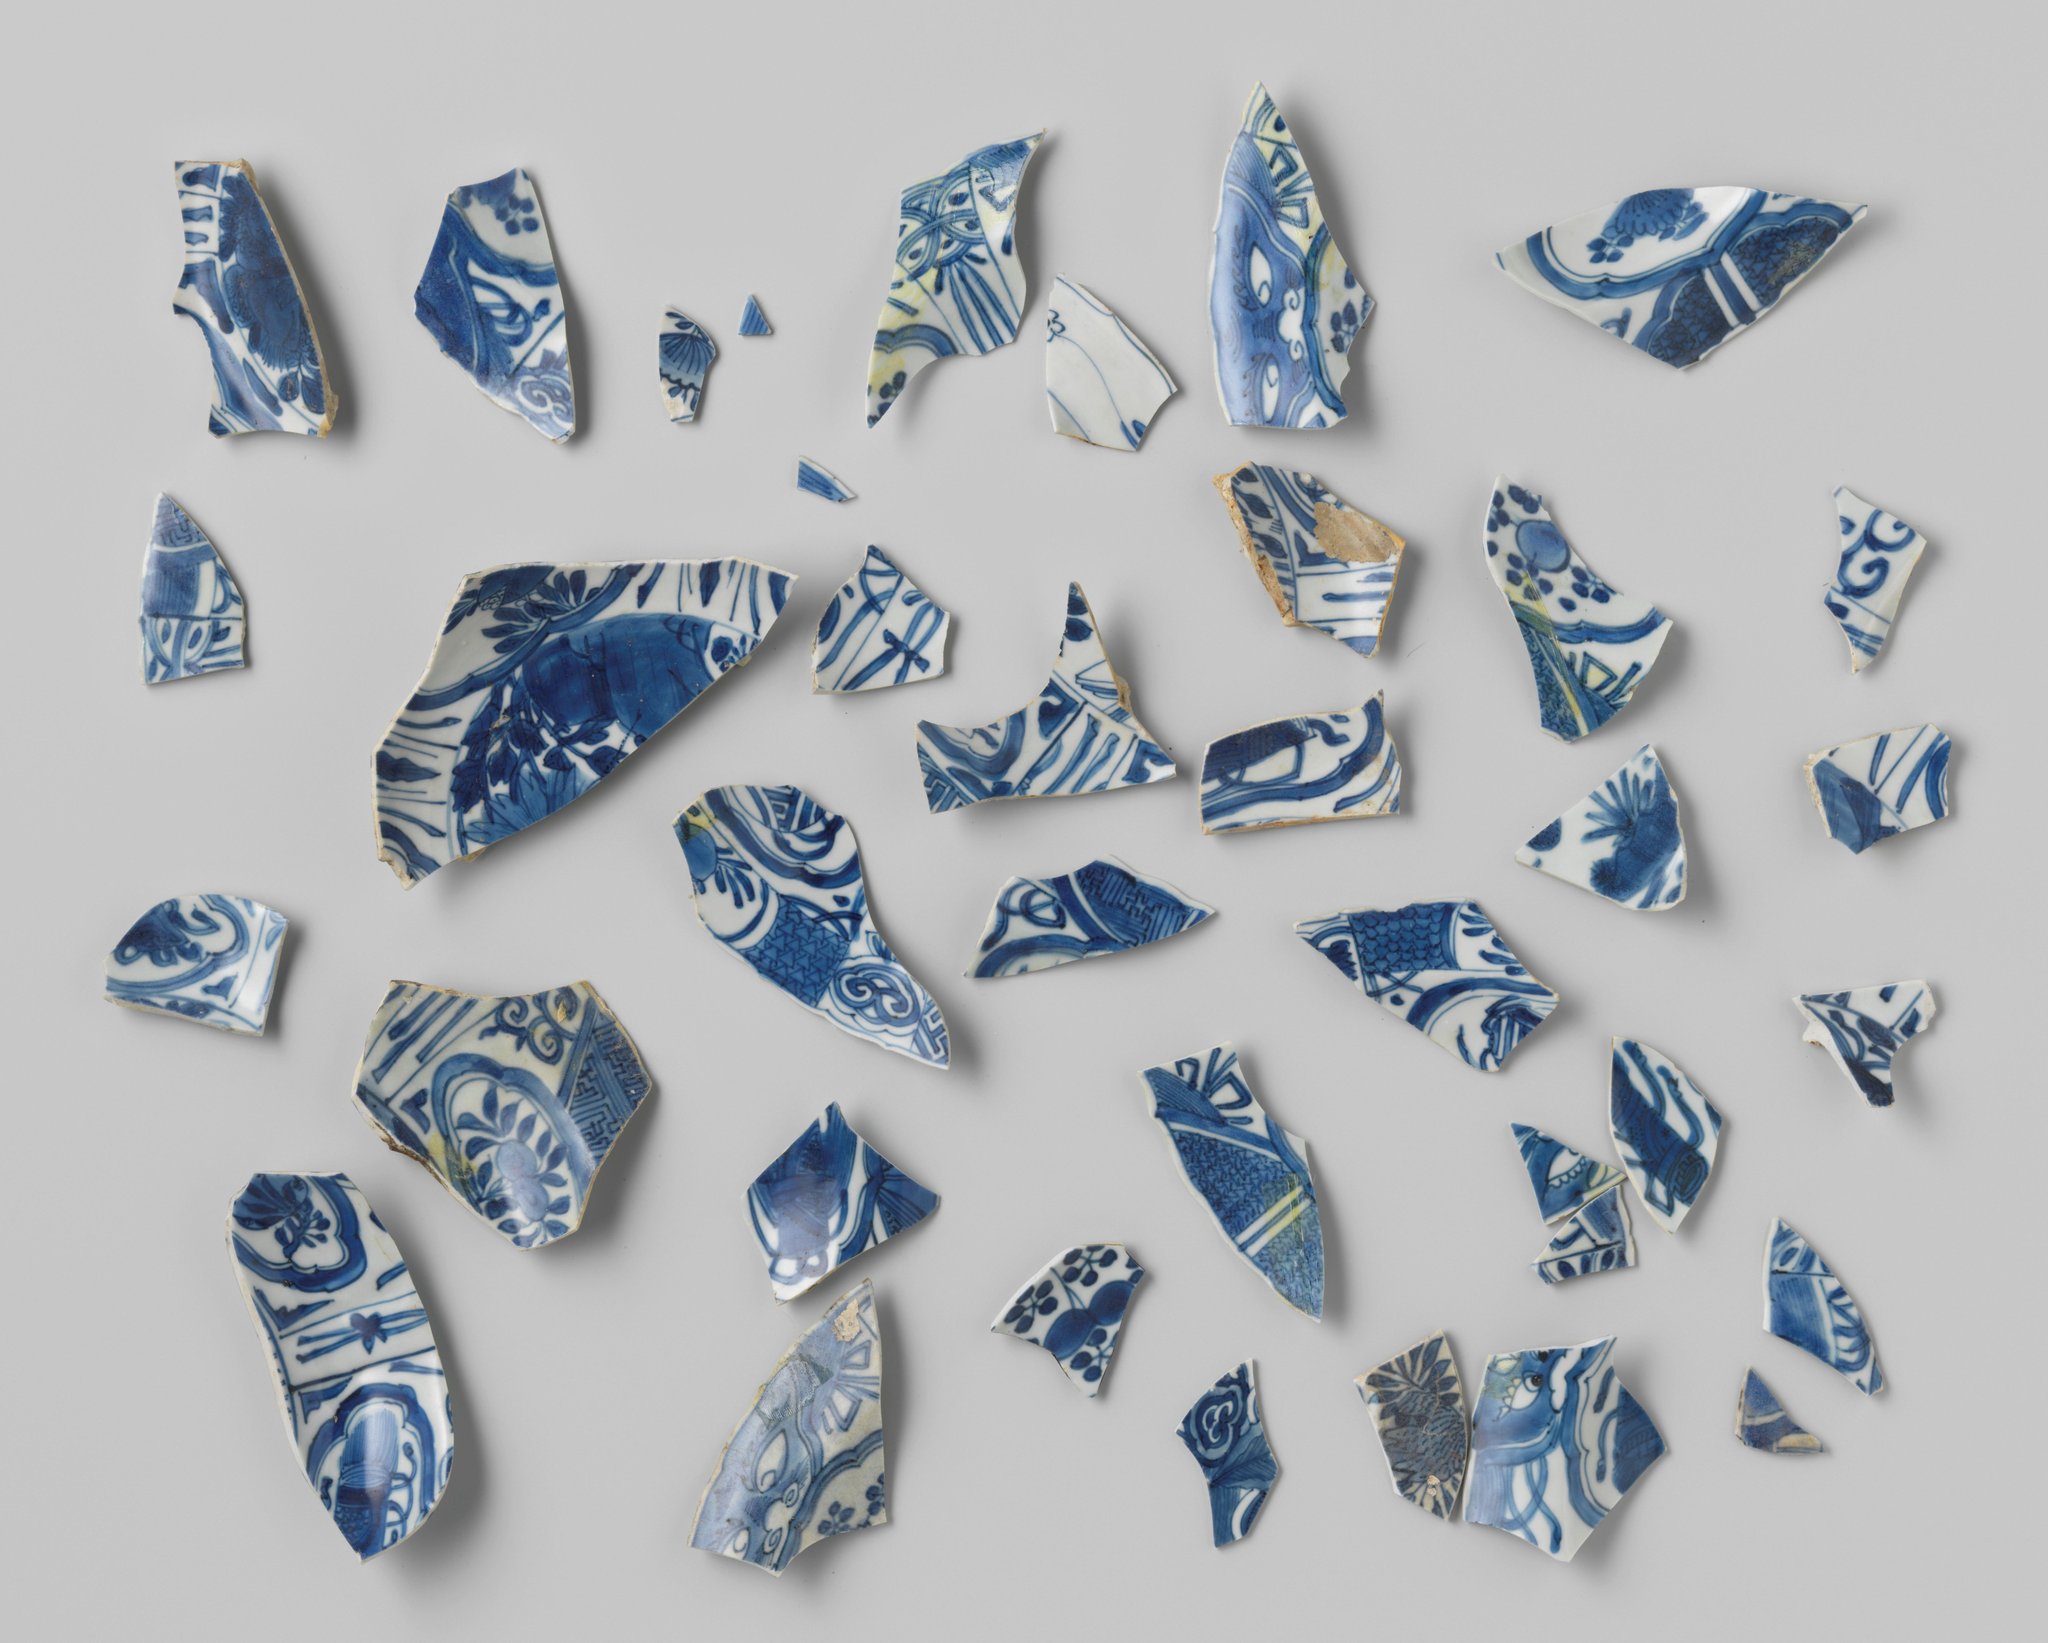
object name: sherd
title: Scherven kraakporselein uit V.O.C.-schip de 'Witte Leeuw'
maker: Anonymous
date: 1613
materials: bone china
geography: jingdezhen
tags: verenigde oostindische compagnie, sint-helena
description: Scherven kraakporselein uit V.O.C.-schip de 'Witte Leeuw'.